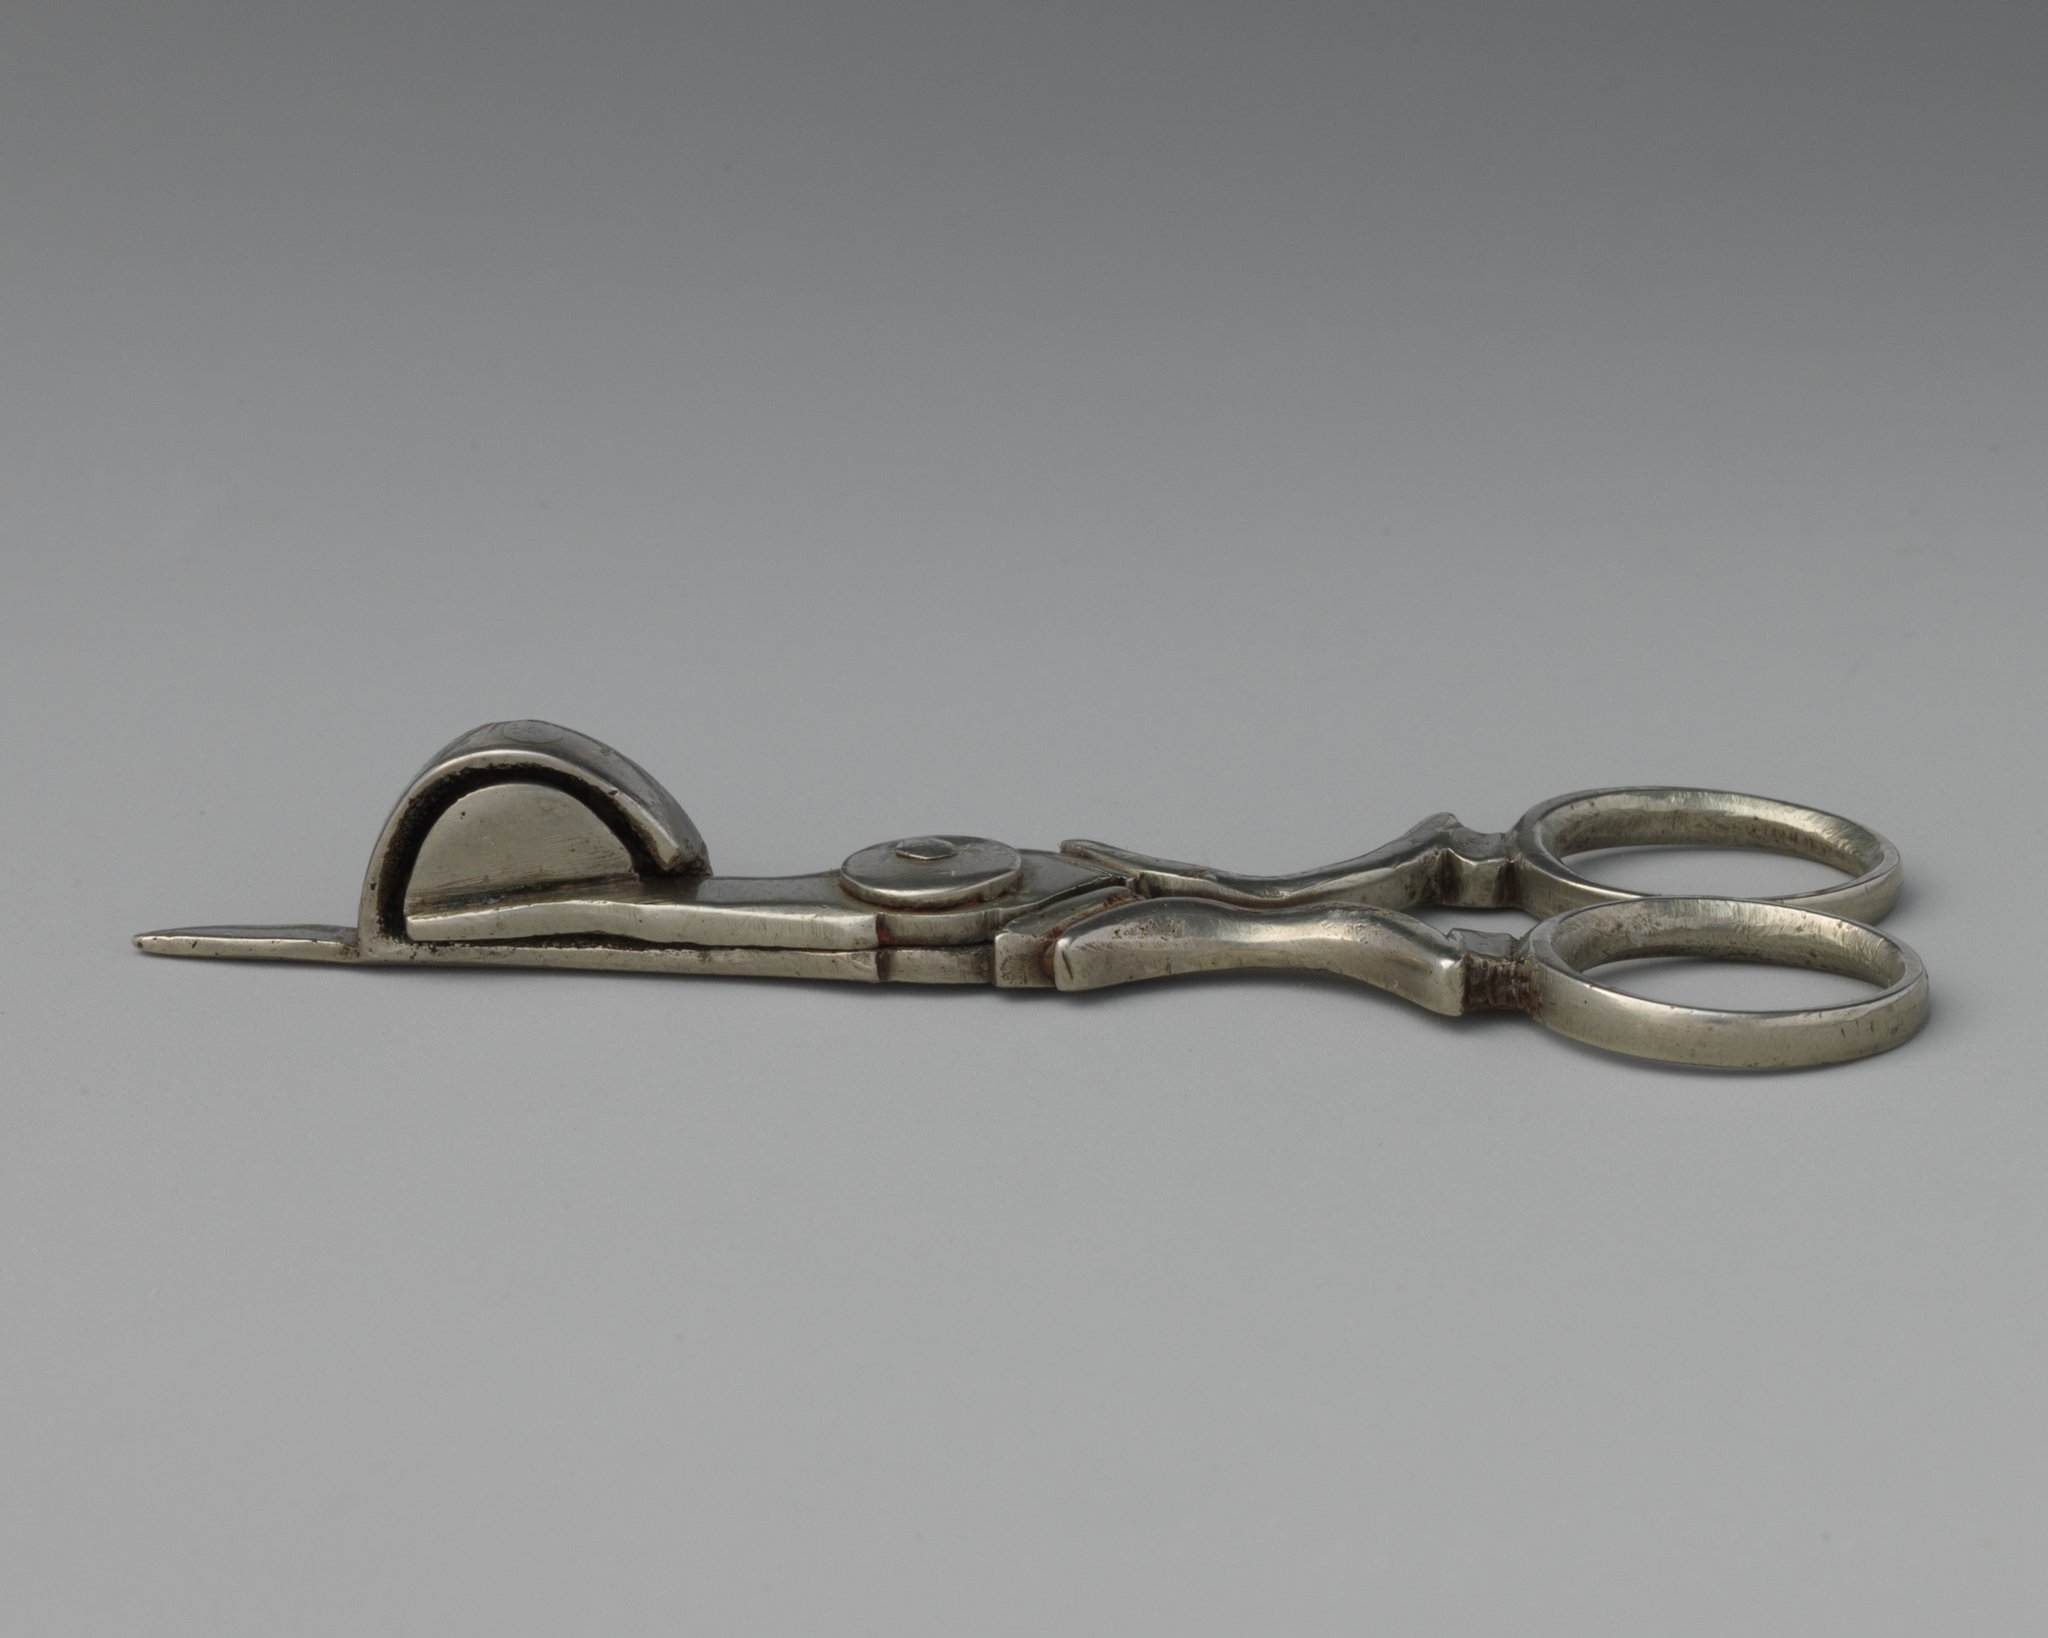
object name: snuffer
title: Miniature snuffers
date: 1701-1800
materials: silver